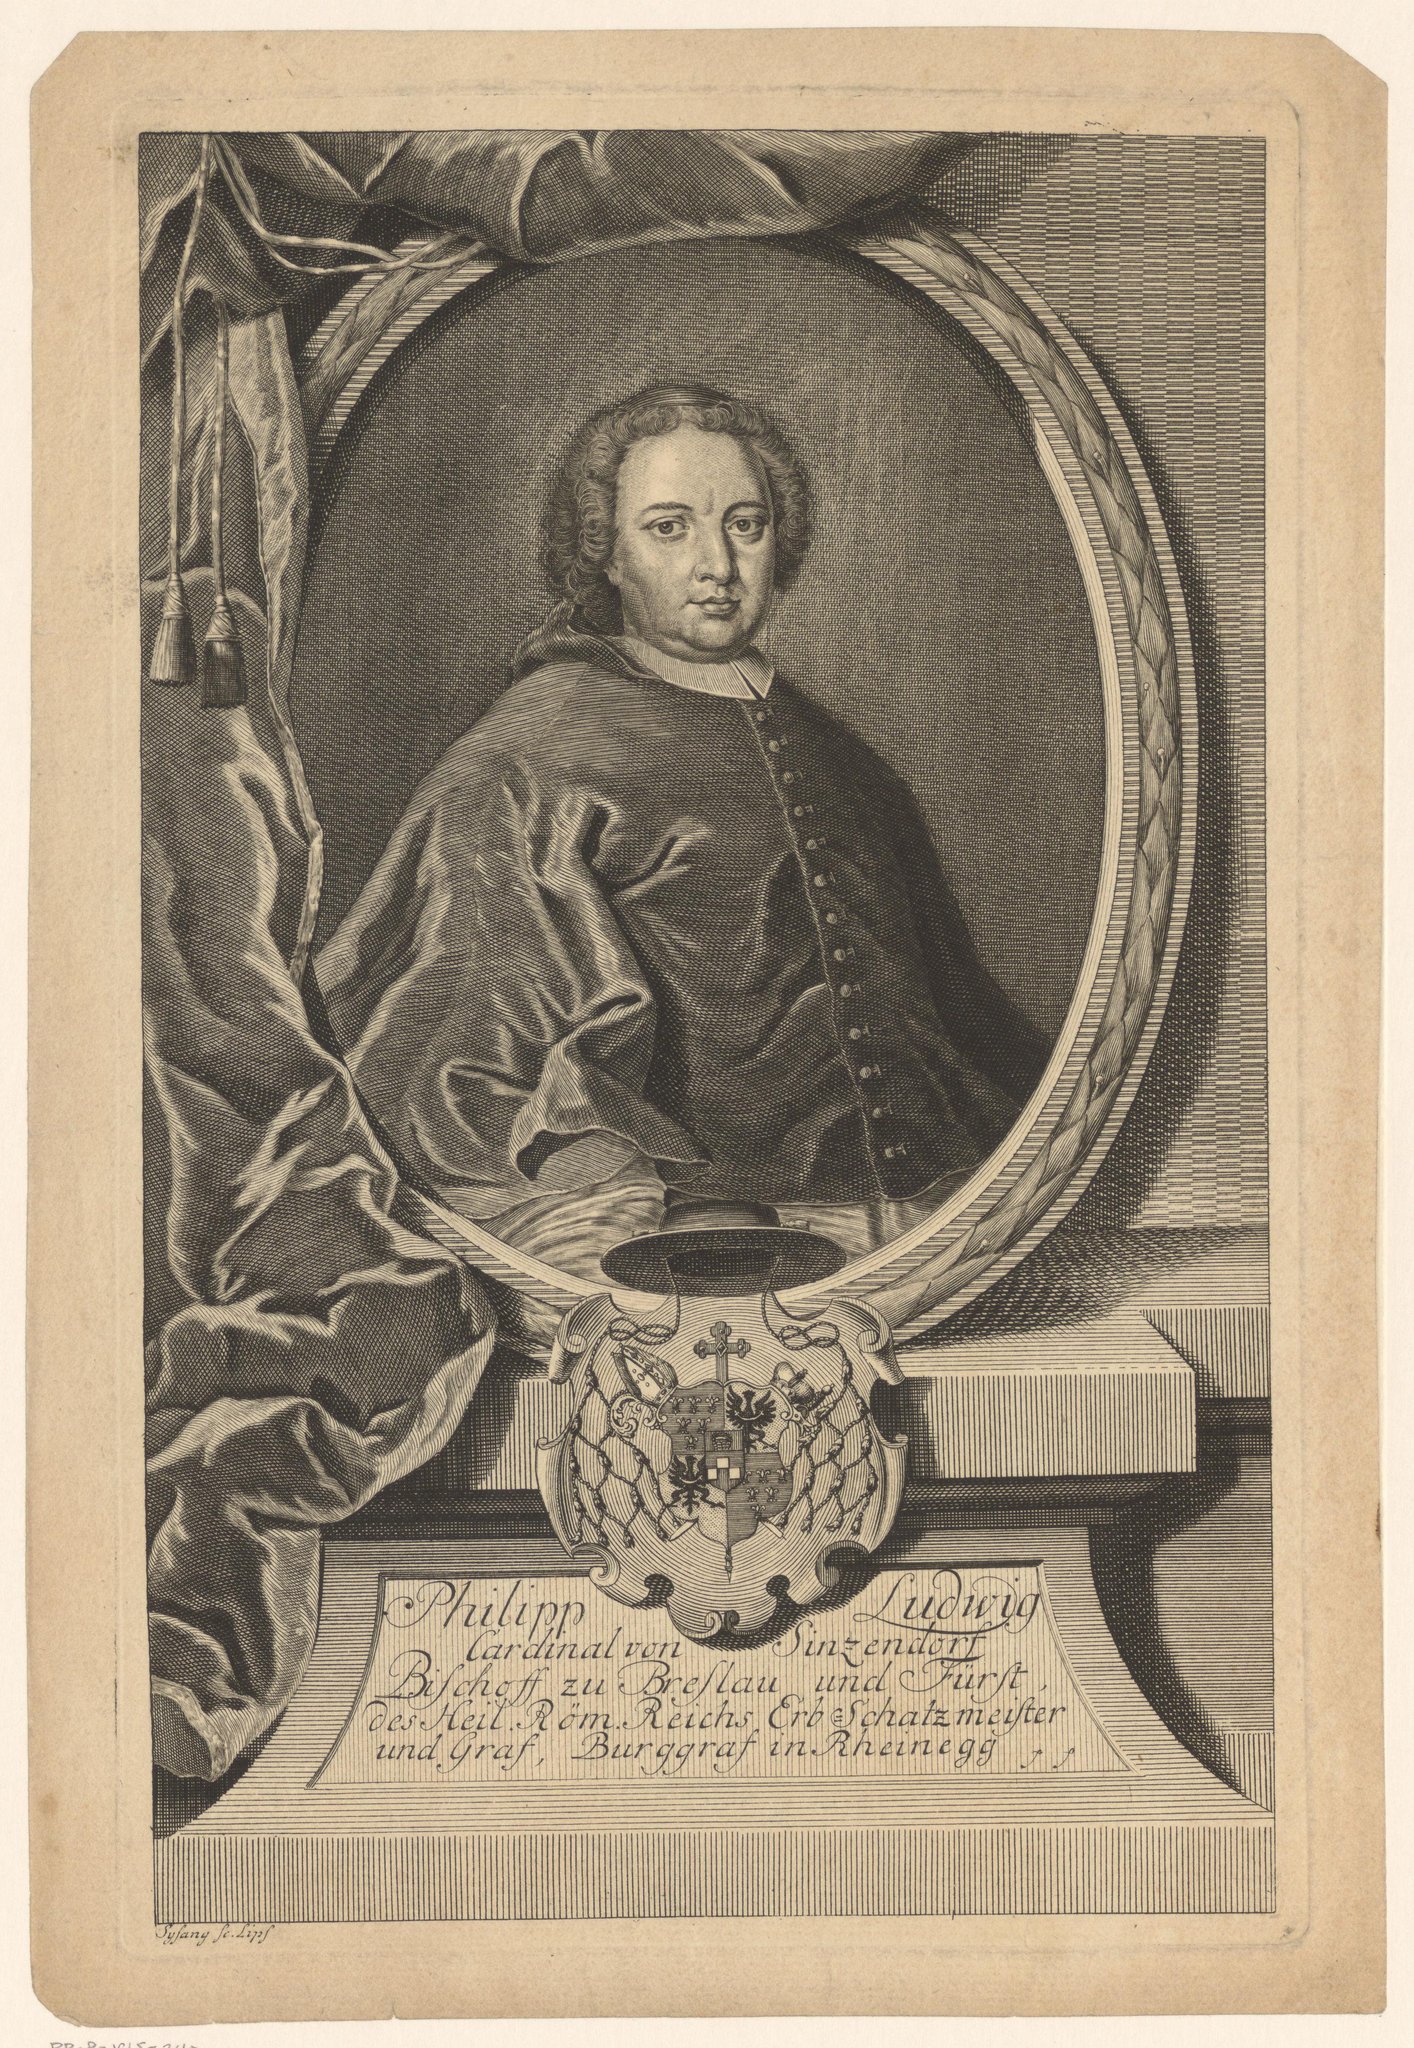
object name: print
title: Portret van Philipp Ludwig, Reichsgraf von Sinzendorf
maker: johann christoph sysang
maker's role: print maker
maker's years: 1703-1757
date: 1732-1757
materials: paper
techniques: engraving, etching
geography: leipzig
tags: paris, cardinal, historical persons, armorial bearing, heraldry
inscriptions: collector's mark: Lugt 2228